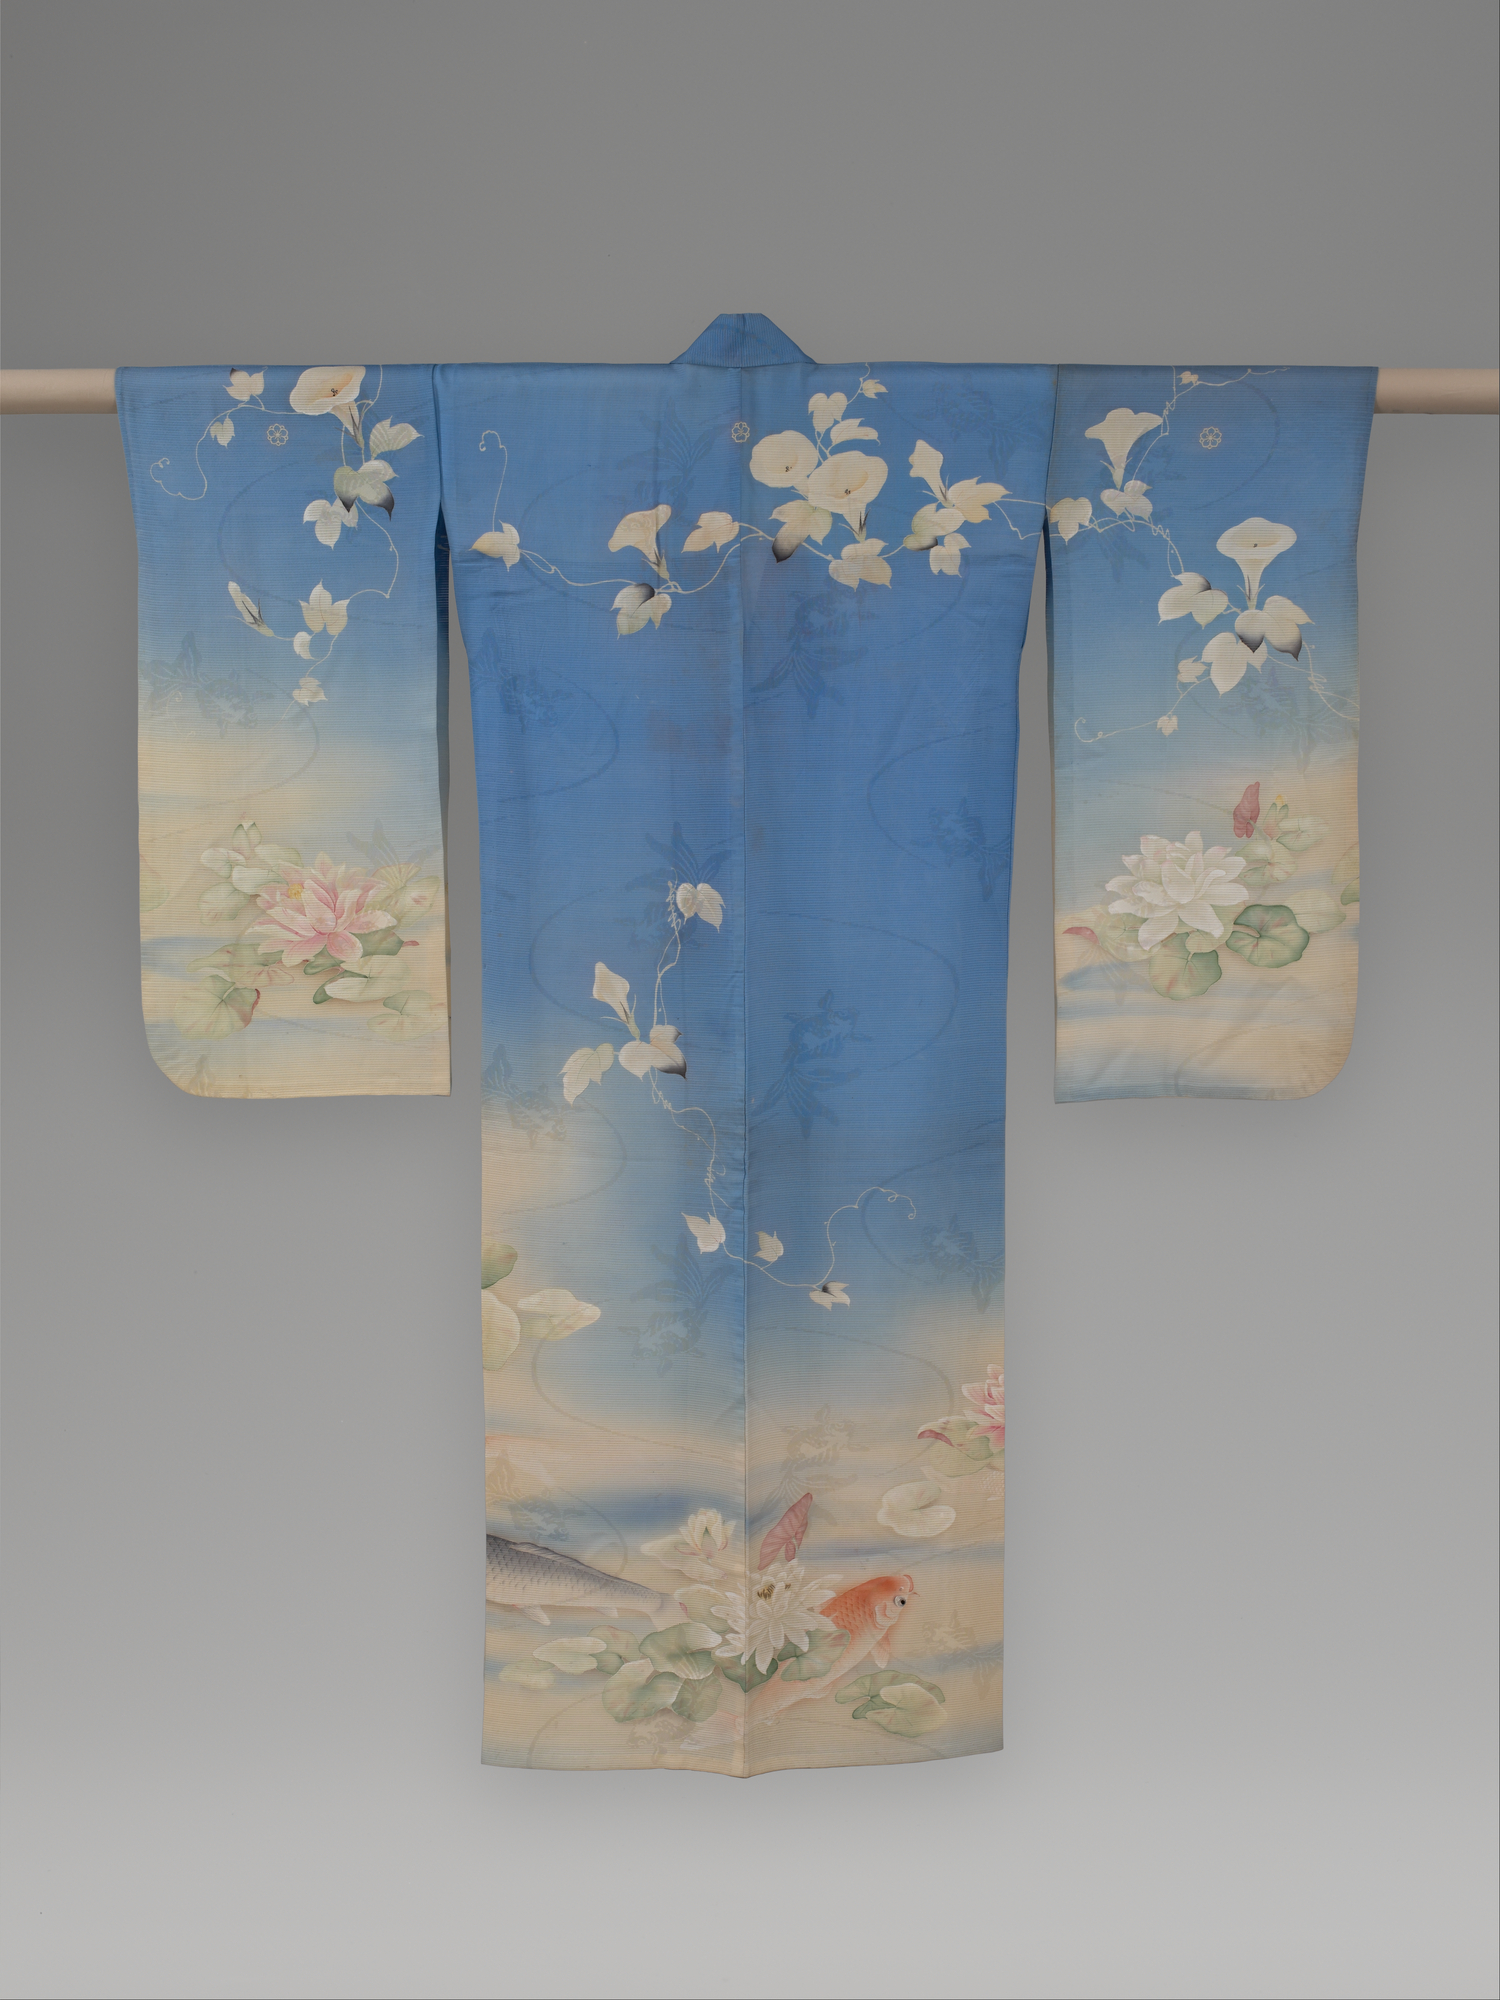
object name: kimono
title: Unlined Summer Kimono (Hito-e) with Carp, Water Lilies, and Morning Glories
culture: japanese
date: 1876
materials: textile, silk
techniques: dyeing, embroidery, painting, patterning, weave, resist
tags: fish,water lilies